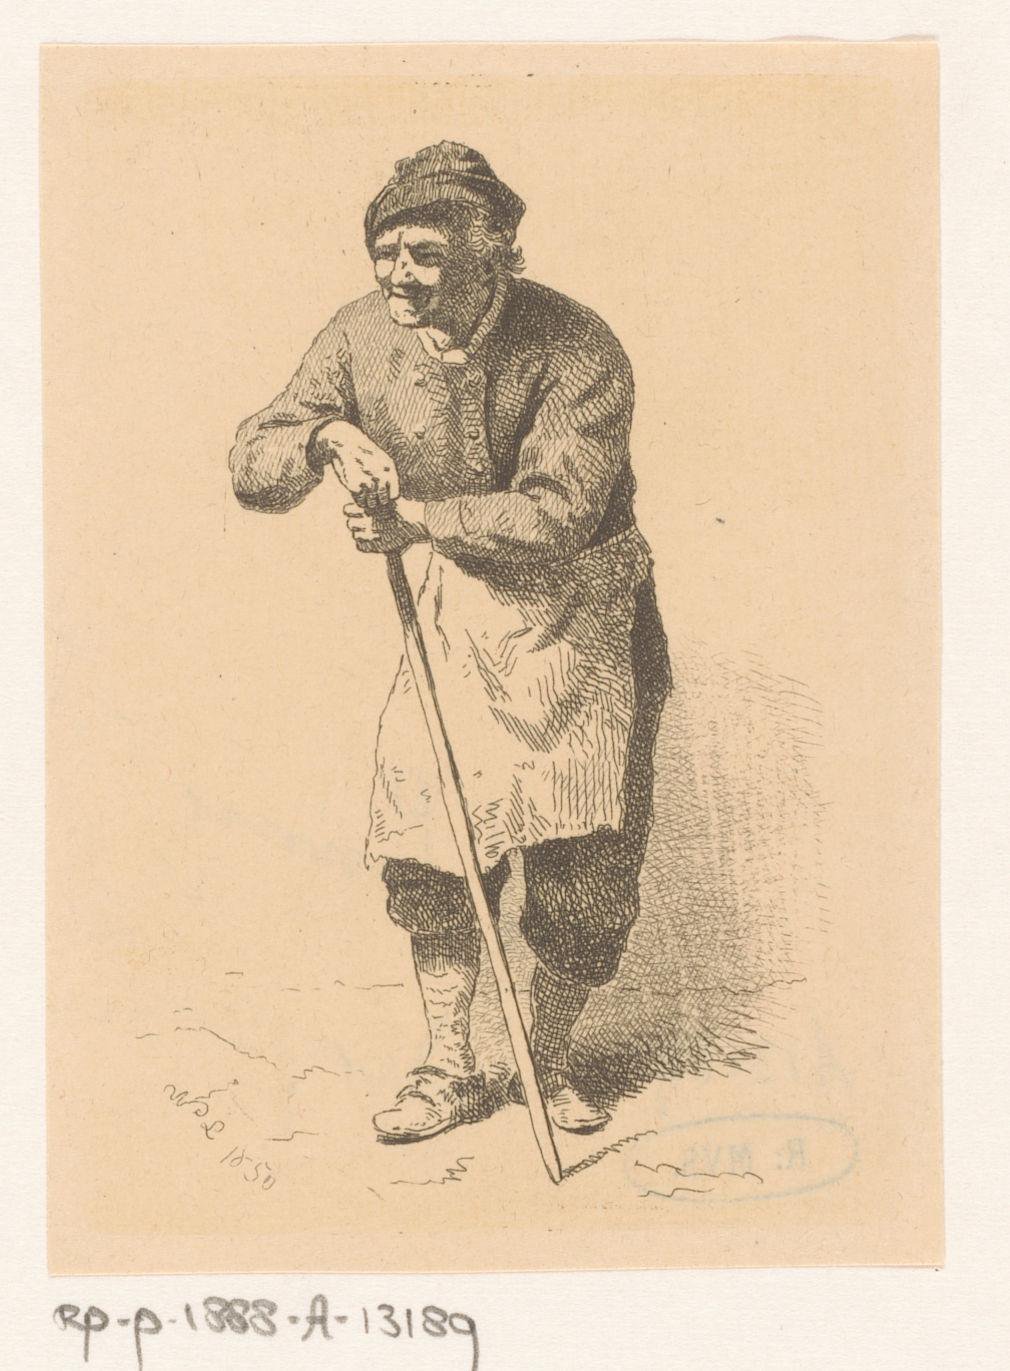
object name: print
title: Oude man leunt op een stok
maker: willem linnig (i)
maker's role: print maker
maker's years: 1819-1885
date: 1850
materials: paper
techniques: etching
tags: old man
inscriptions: collector's mark: Lugt 2228